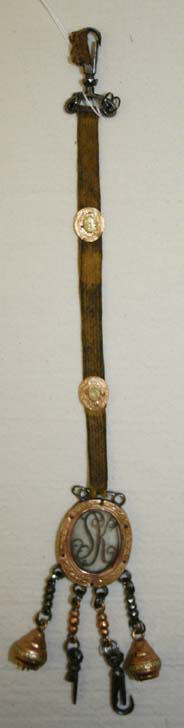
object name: fob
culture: british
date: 1767-1800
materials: metal, silk